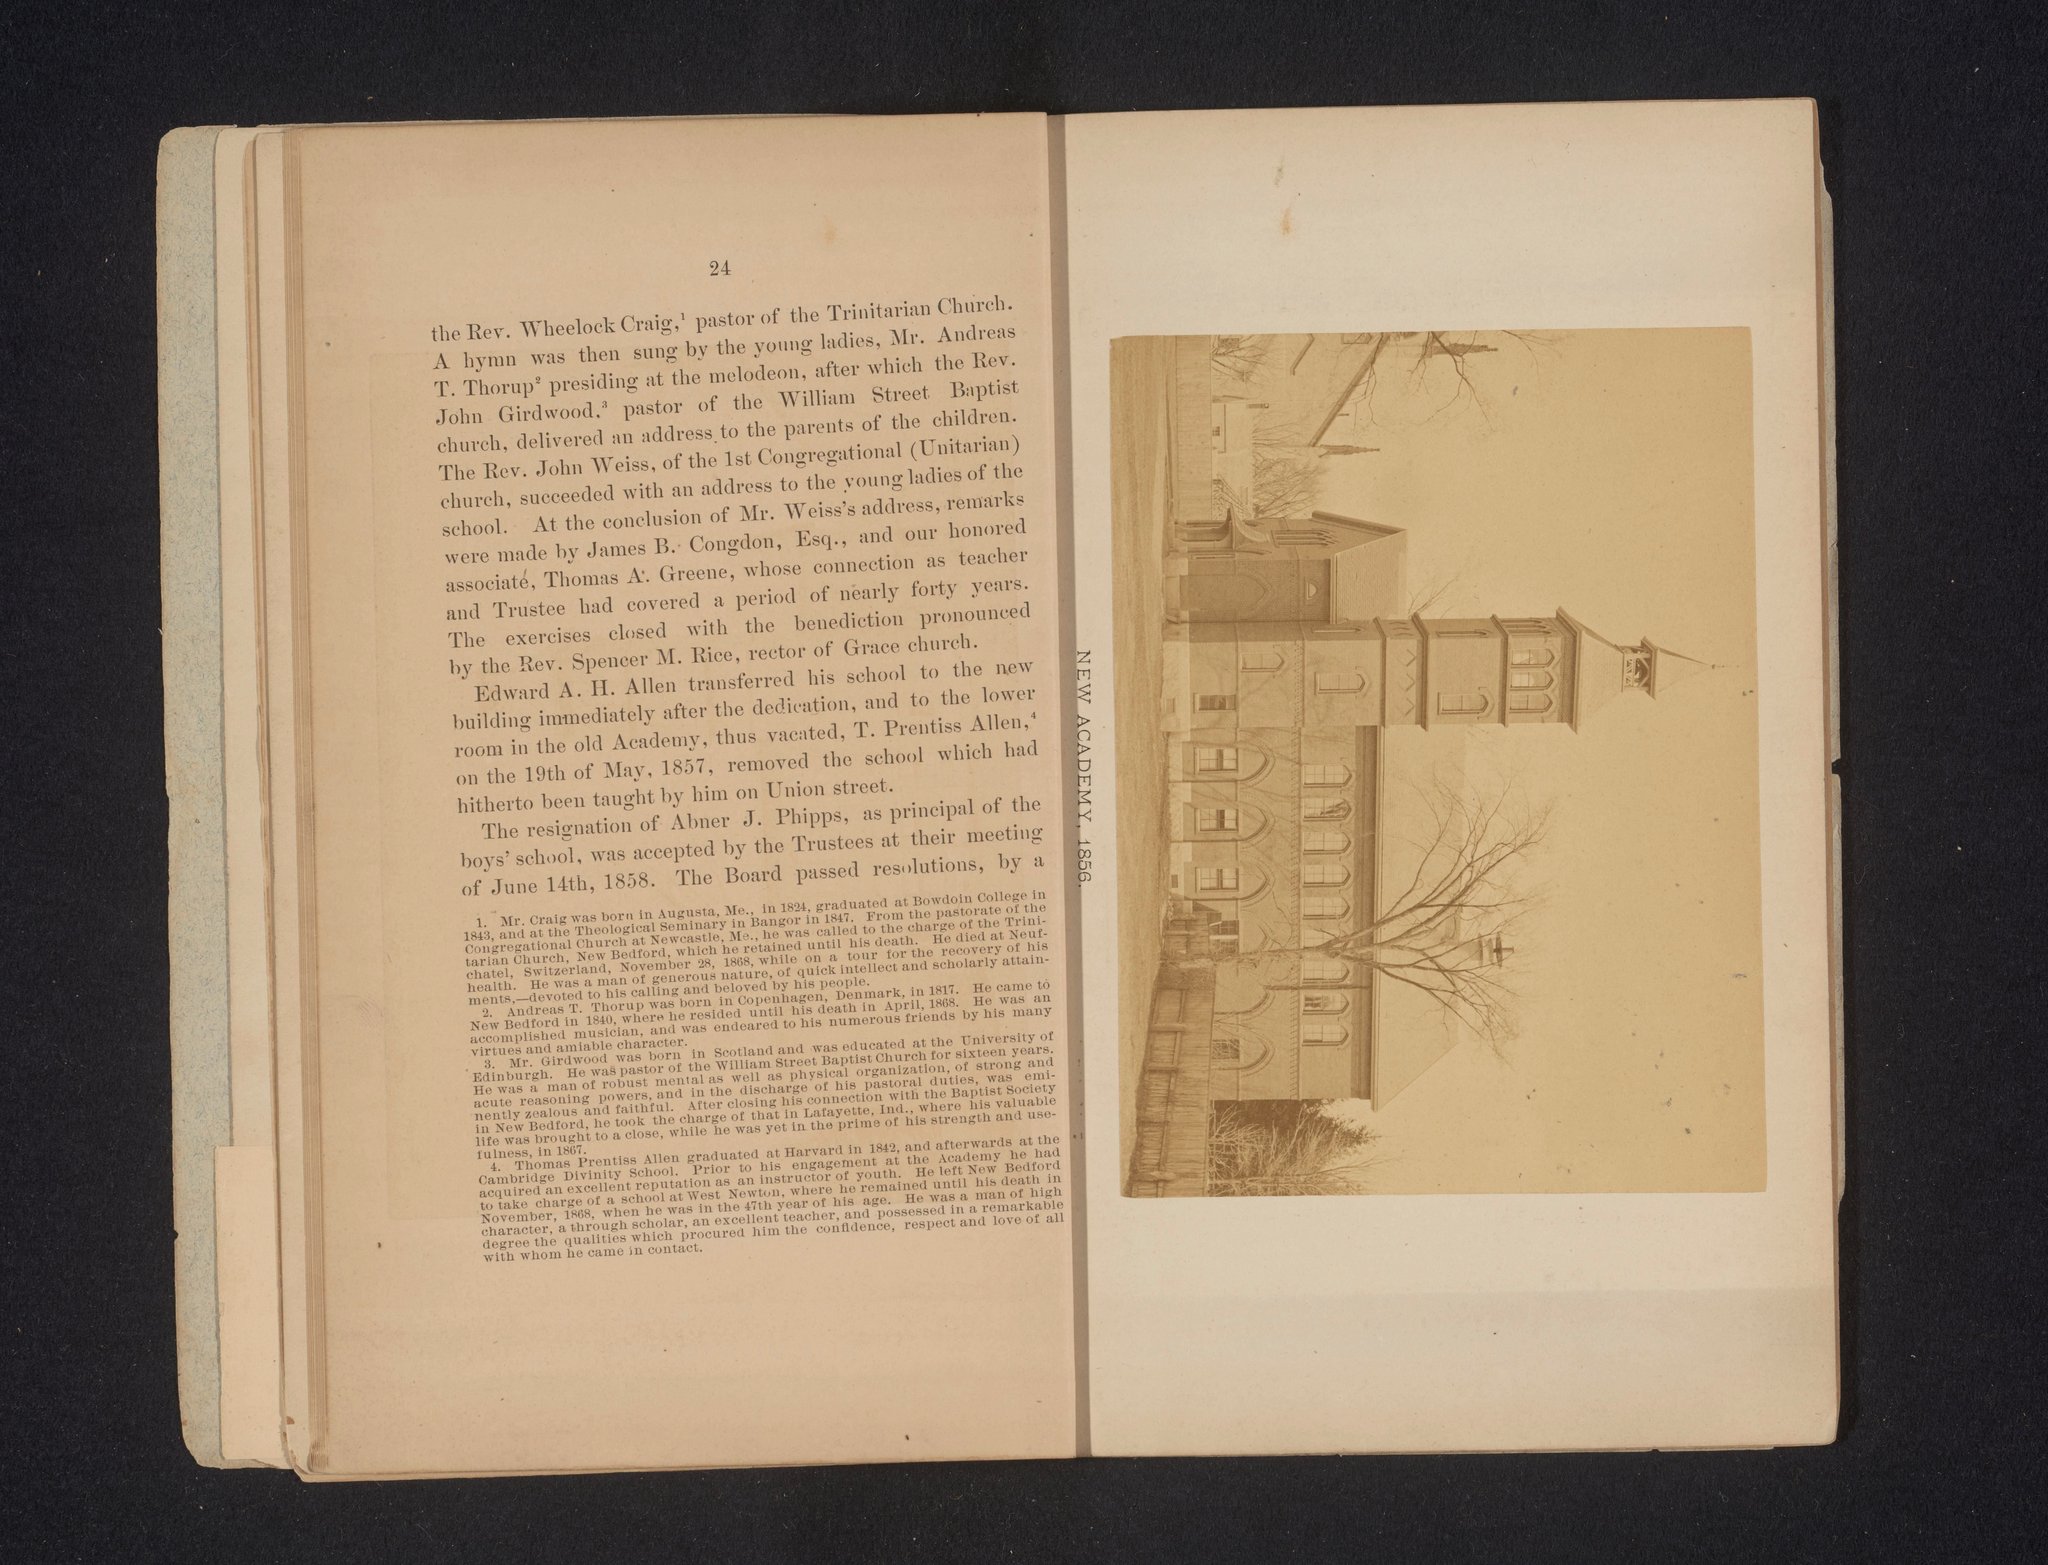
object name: page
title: New Academy. 1856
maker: Anonymous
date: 1871-1876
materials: photographic support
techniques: albumen print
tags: scholastic education, tuition, civic architecture; edifices; dwellings